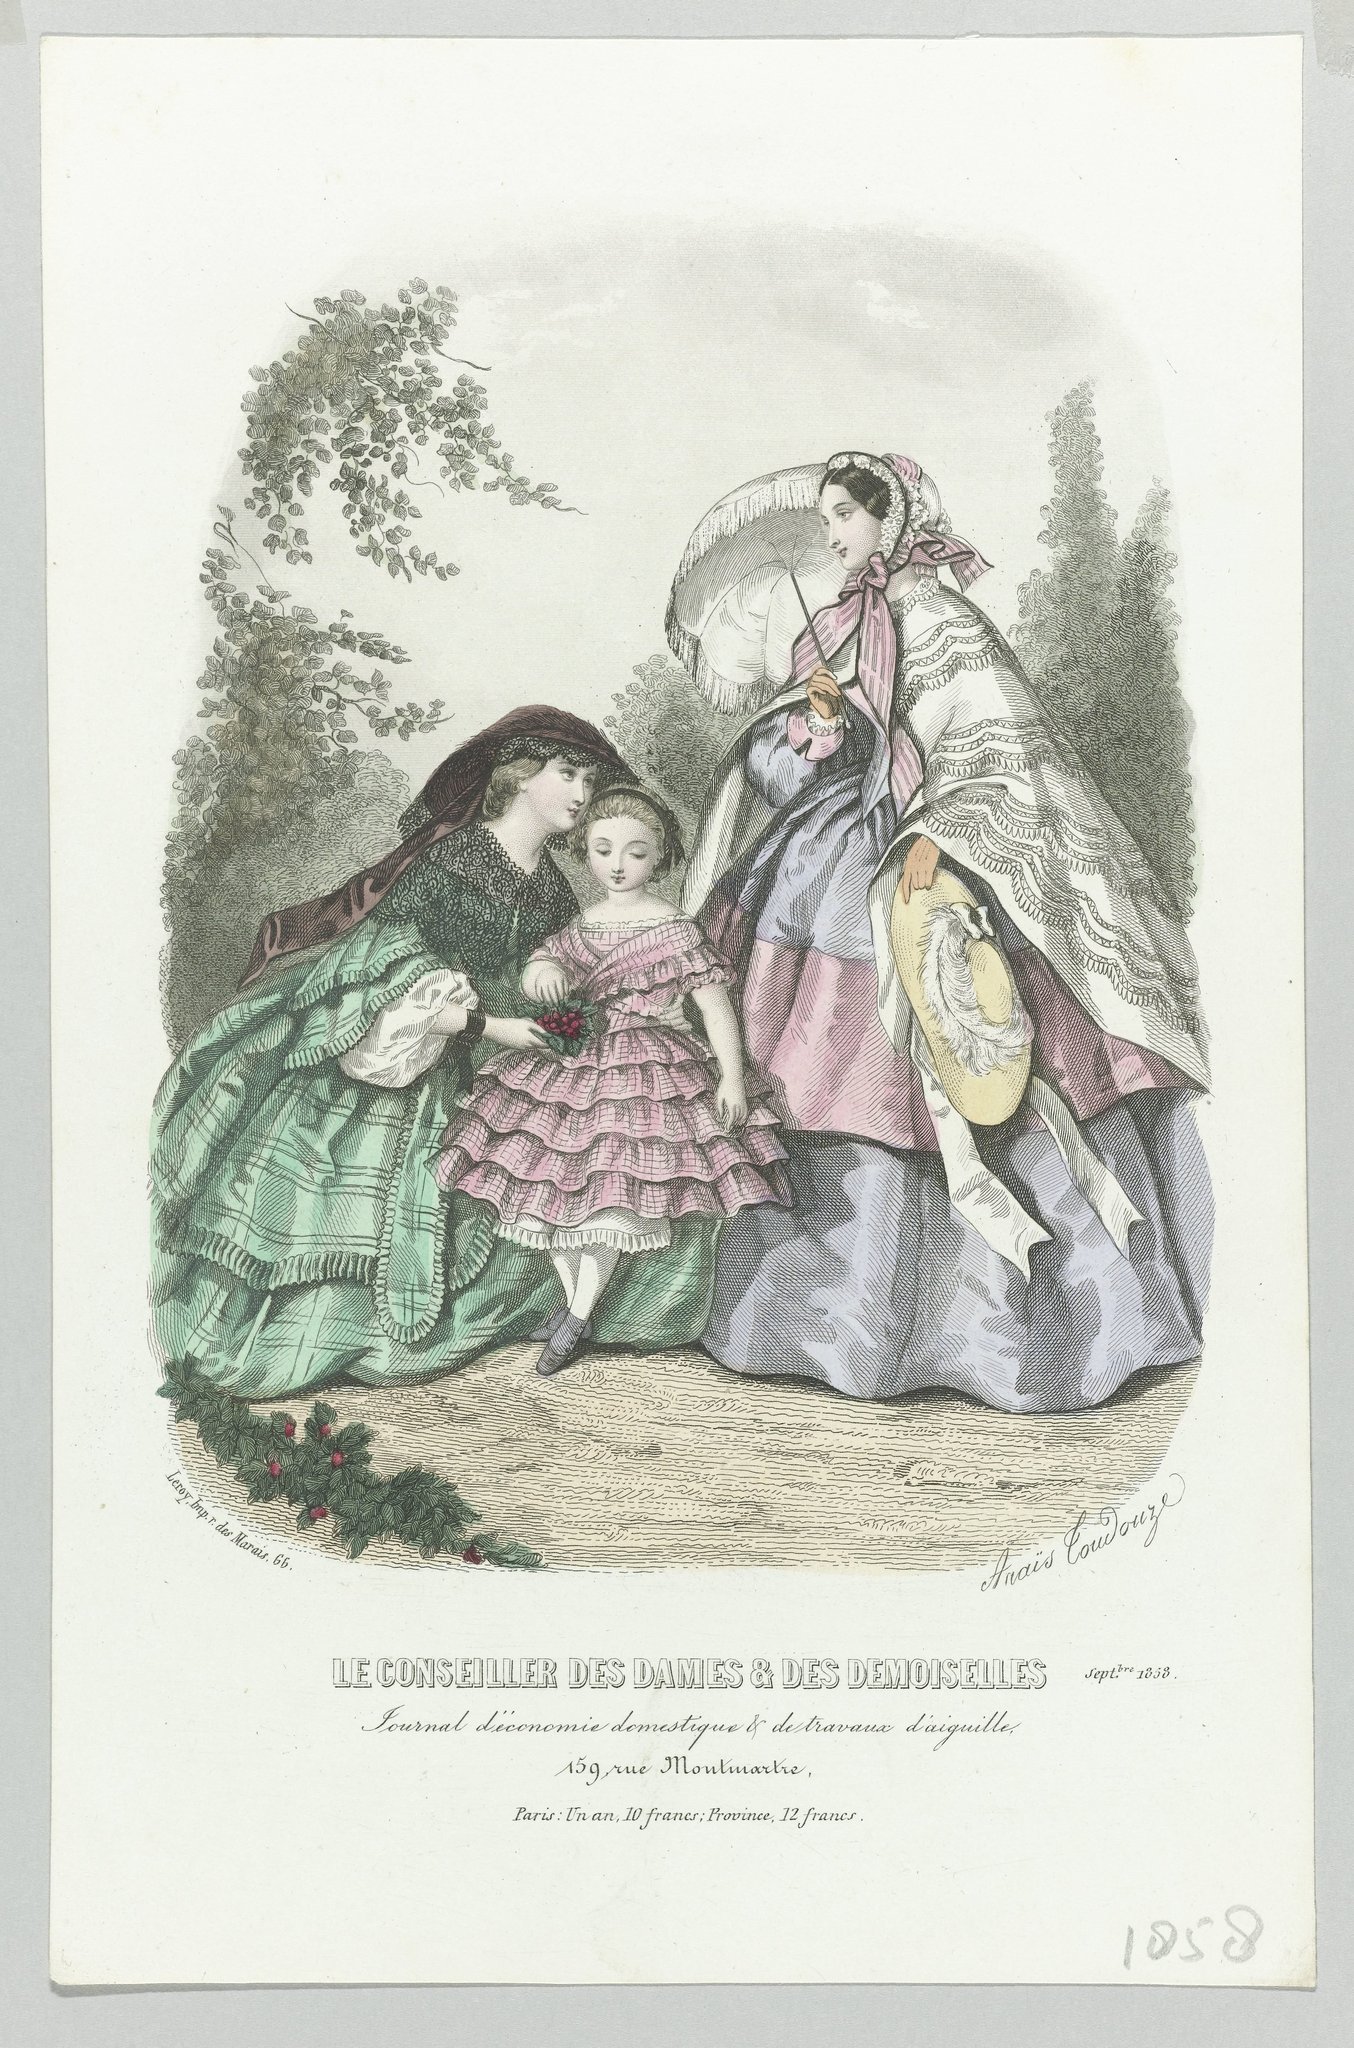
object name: fashion print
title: Le Conseiller des Dames et Des Demoiselles, septembre 1858 : Journal d'économi (...)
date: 1858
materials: paper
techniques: engraving, hand coloring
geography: paris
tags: clothes, costume (+ girls' clothes), coat (+ women's clothes), head-gear (+ women's clothes), fashion plates, gloves, mittens, etc. (+ women's clothes), bracelet, wristlet (+ women's clothes), parasol, sunshade (+ women's clothes)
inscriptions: title: ‘Le Conseiller des Dames & Des Demoiselles’, caption: ‘Journal d'économie domestique & de travaux d'aiguille.’, address: ‘159, rue Montmartre. / Paris, Un an, 10 francs; Province, 12 francs.’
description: Vrouw, staande, in een mantel en wijde rok. Parasol afgezet met franjes. In de hand een platte grote hoed met striklinten. Vrouw in een geruite japon met wijd uitlopende mouwen en poffende ondermouwen. Kinderkleding: meisje in geruite japon en 'bloomers'. Enkellaarsjes. Prent uit het modetijdschrift Le Conseiller des Dames (1847-1892).